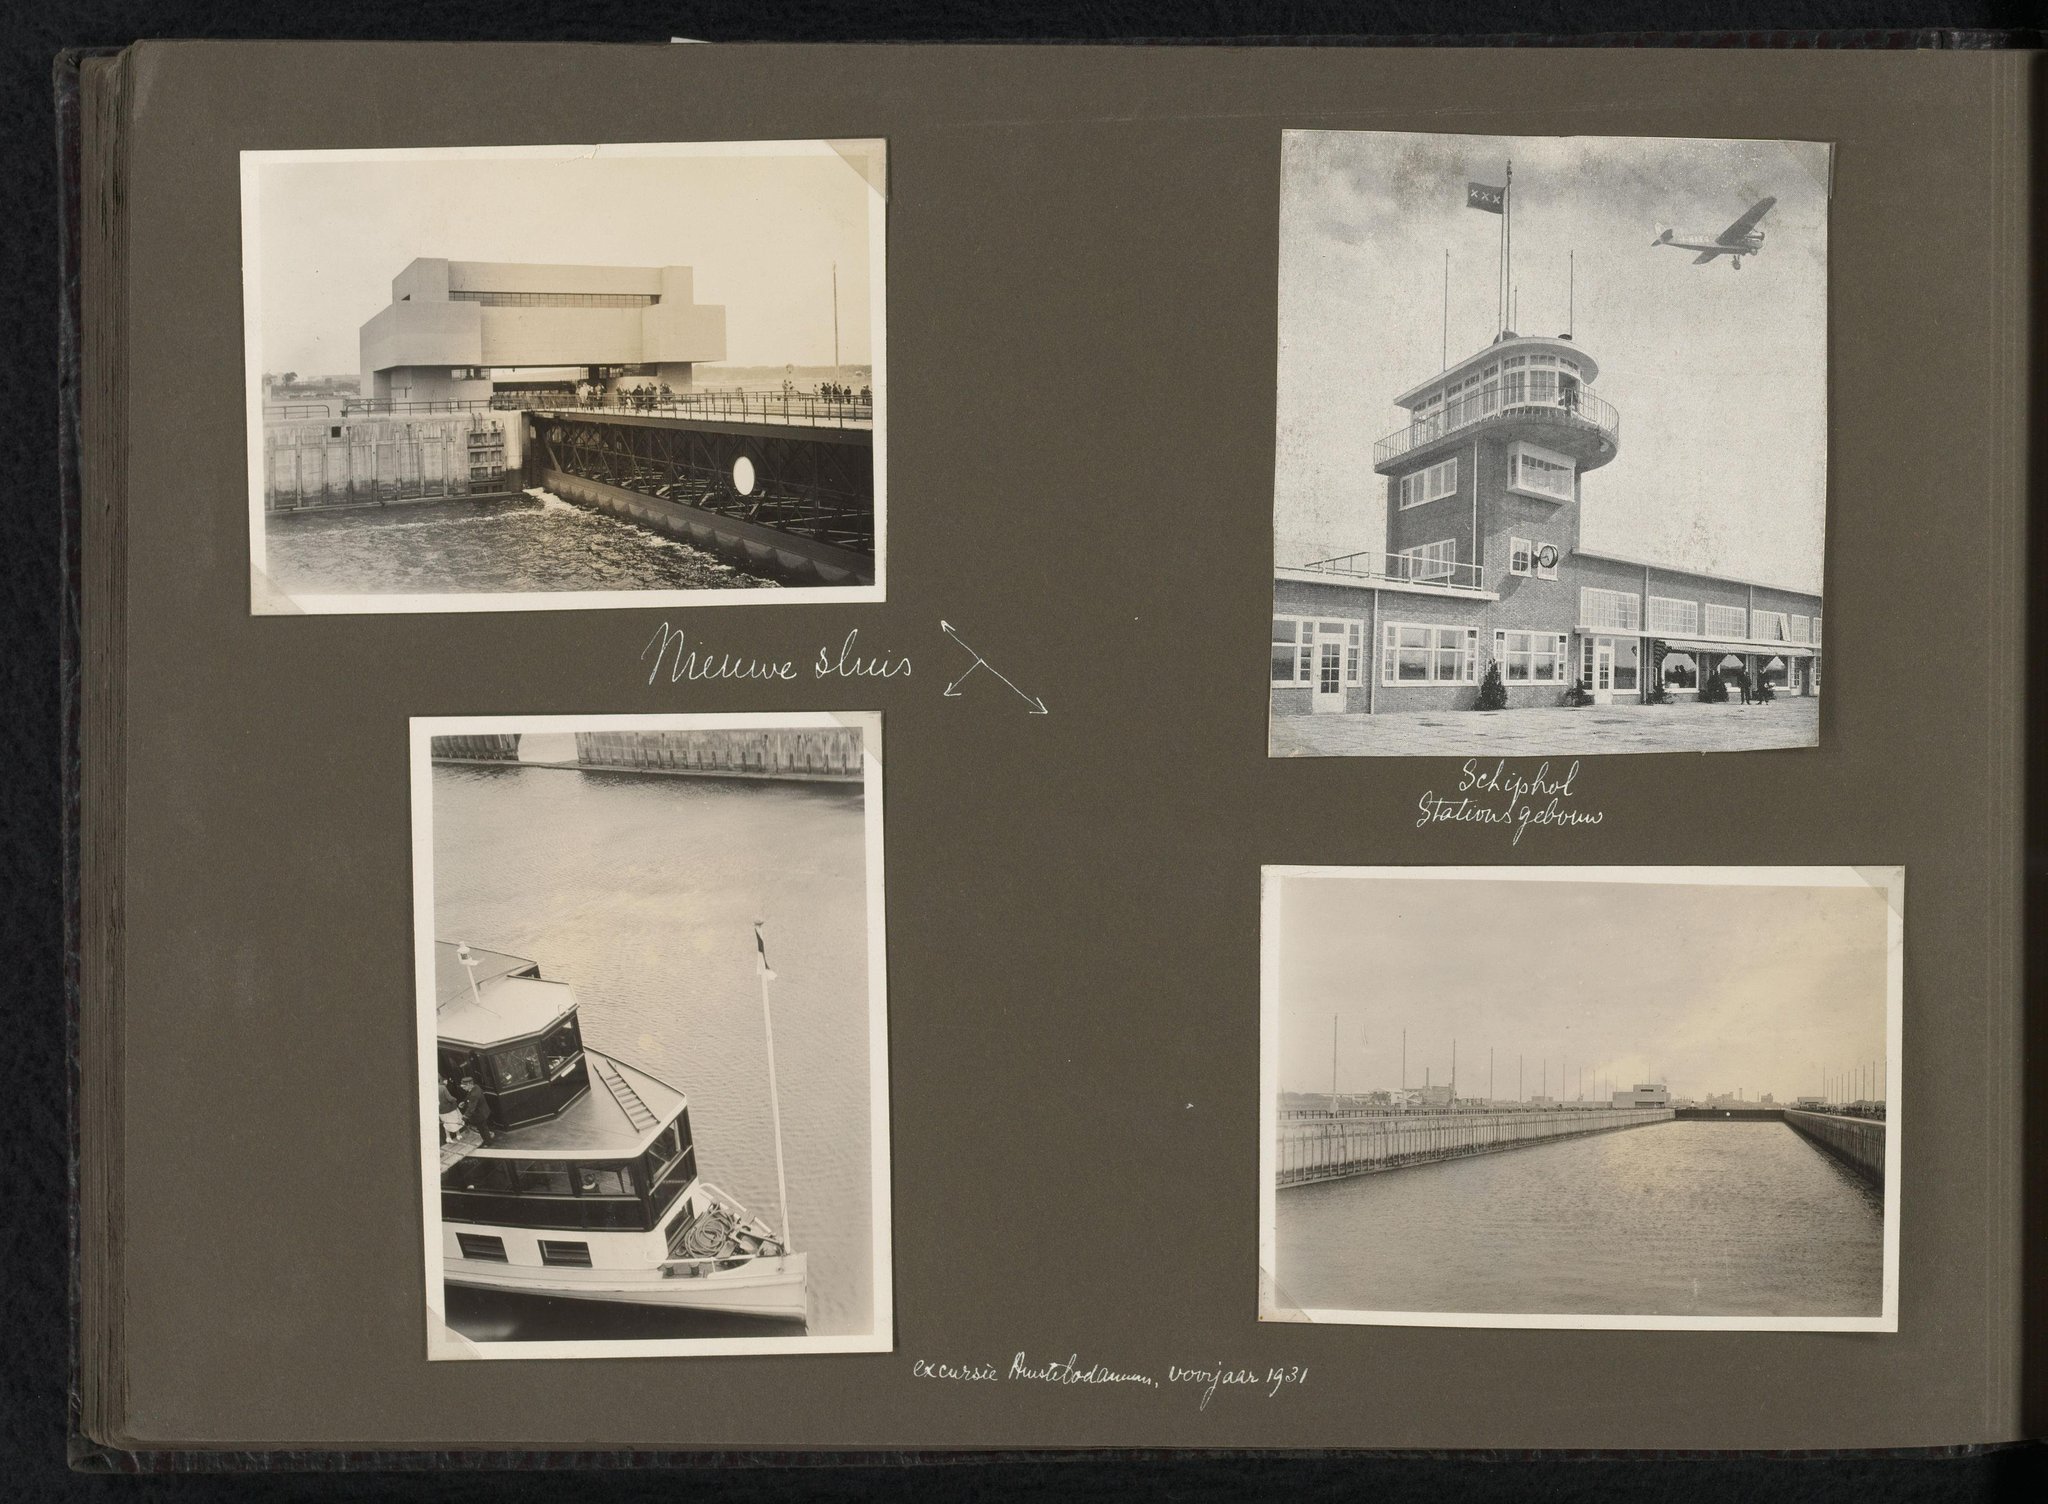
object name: photomechanical print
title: Drie foto's van een sluis bij Amsterdam en een fotomechanische afdruk van Schiphol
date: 1931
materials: paper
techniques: gelatin silver print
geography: schiphol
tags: sluice, weir, airfield, airport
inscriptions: inscription: ‘Nieuwe sluis’, inscription: ‘Schiphol/ Stationsgebouw’, inscription: ‘excursie Amstelodamum, voorjaar 1931’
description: Deze foto's en prent maken deel uit van een album.